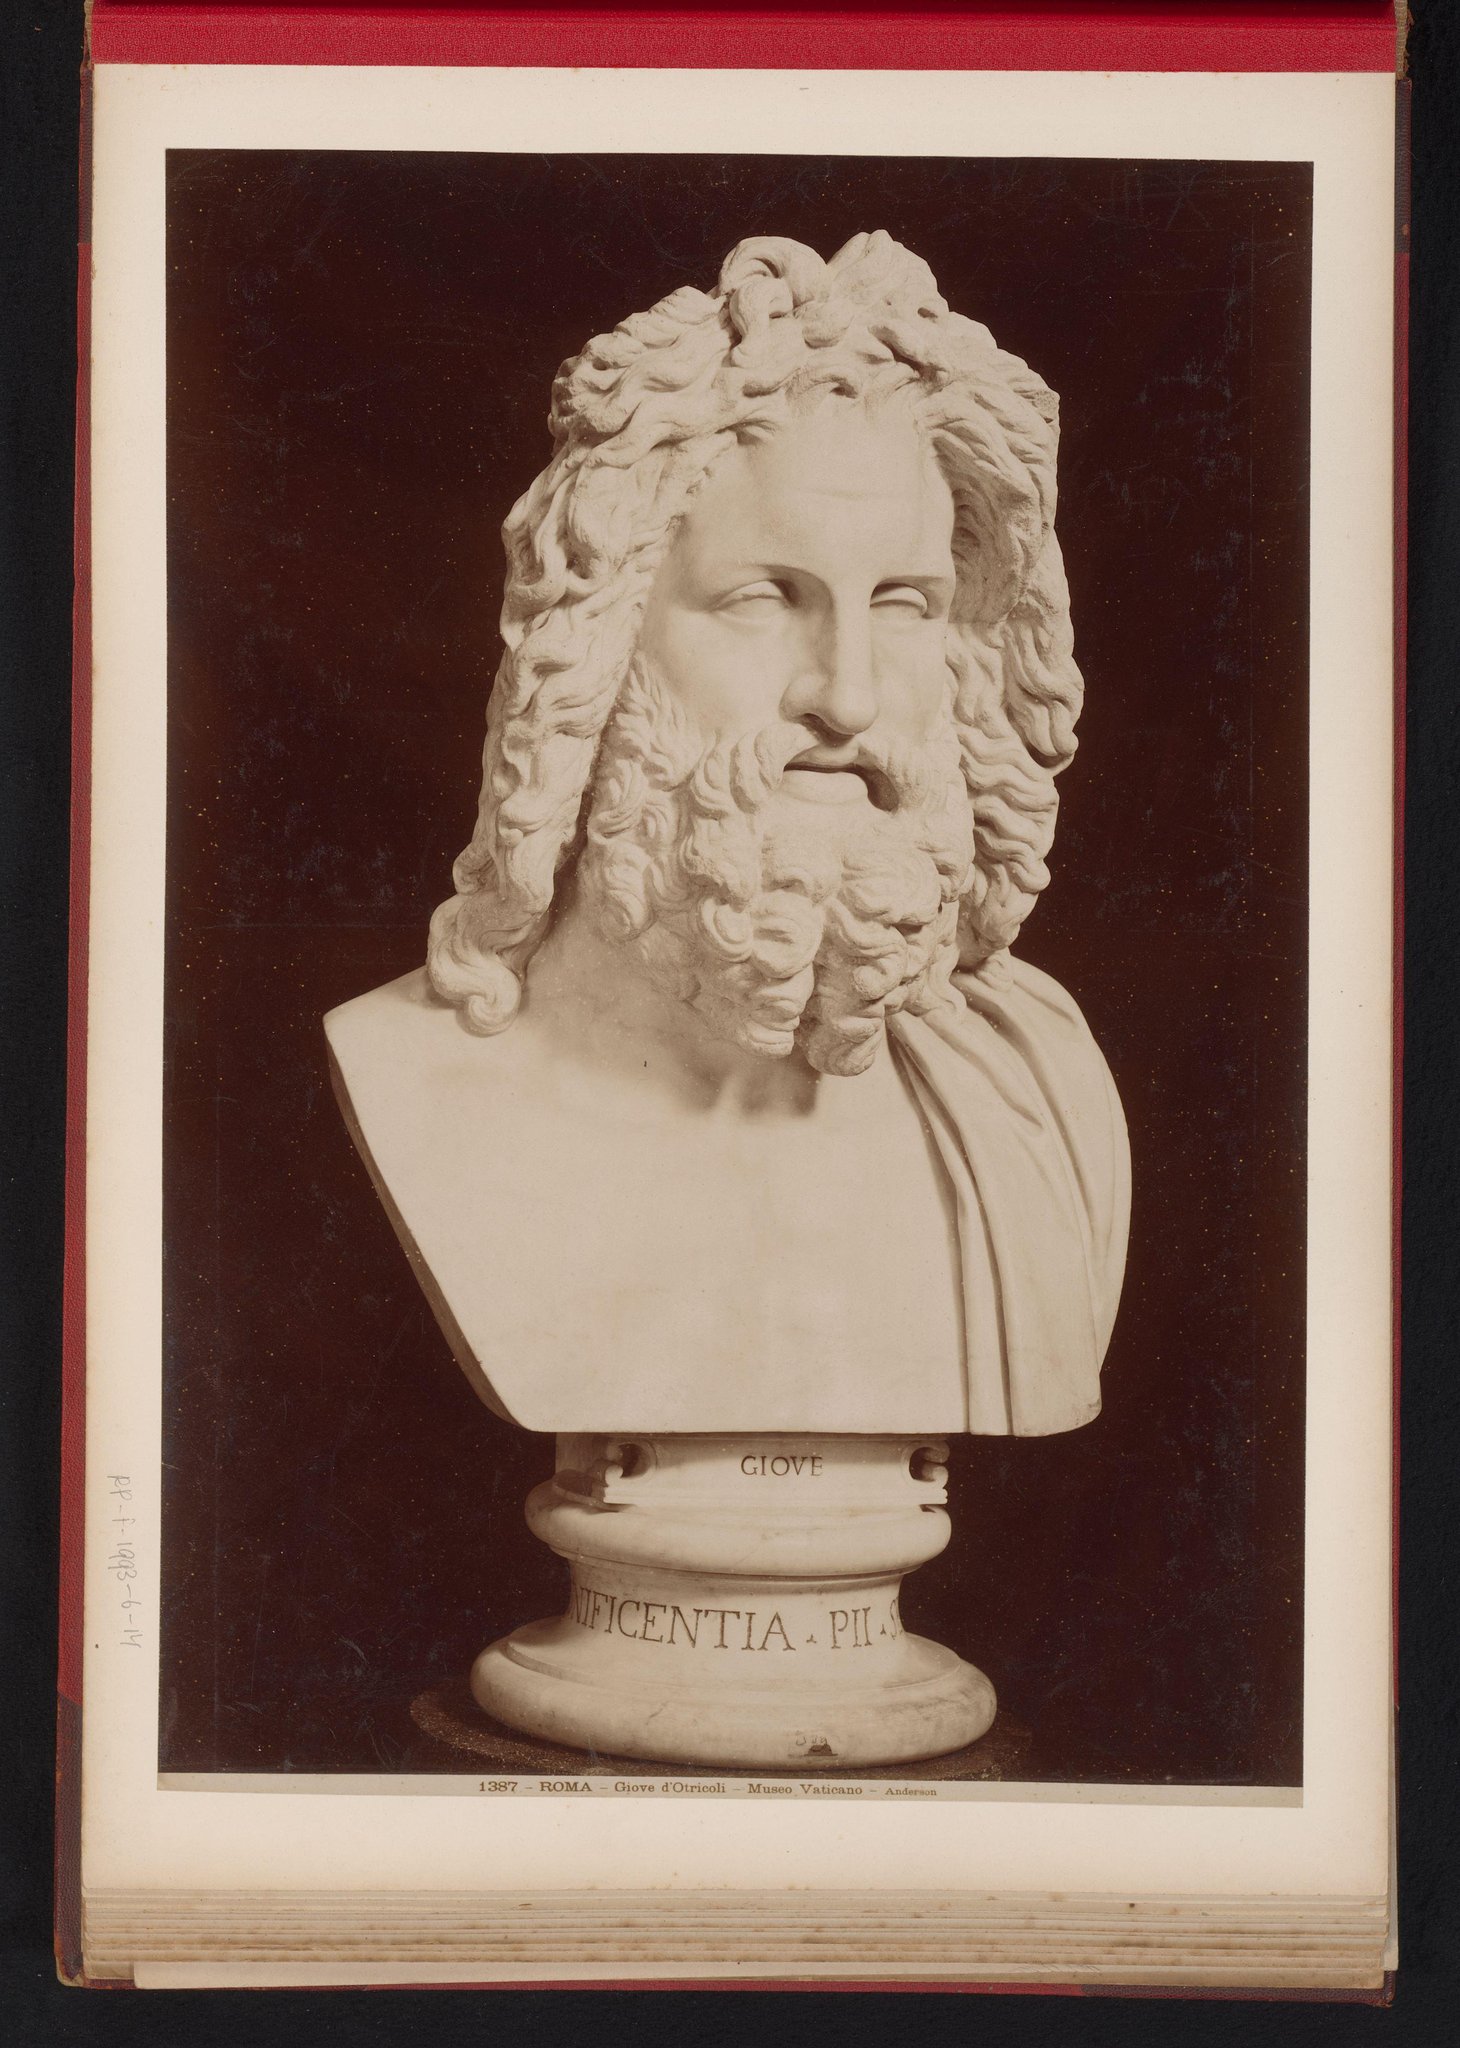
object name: album leaf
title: Buste van Jupiter, Vaticaan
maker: james anderson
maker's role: fotograaf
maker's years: 1813-1877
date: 1857-1875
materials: paper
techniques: albumen print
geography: vatican museums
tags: (story of) jupiter (zeus), piece of sculpture, reproduction of a piece of sculpture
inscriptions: inscription: ‘1387 - ROMA - Giove d'Otricoli - Museo Vaticano - Anderson’